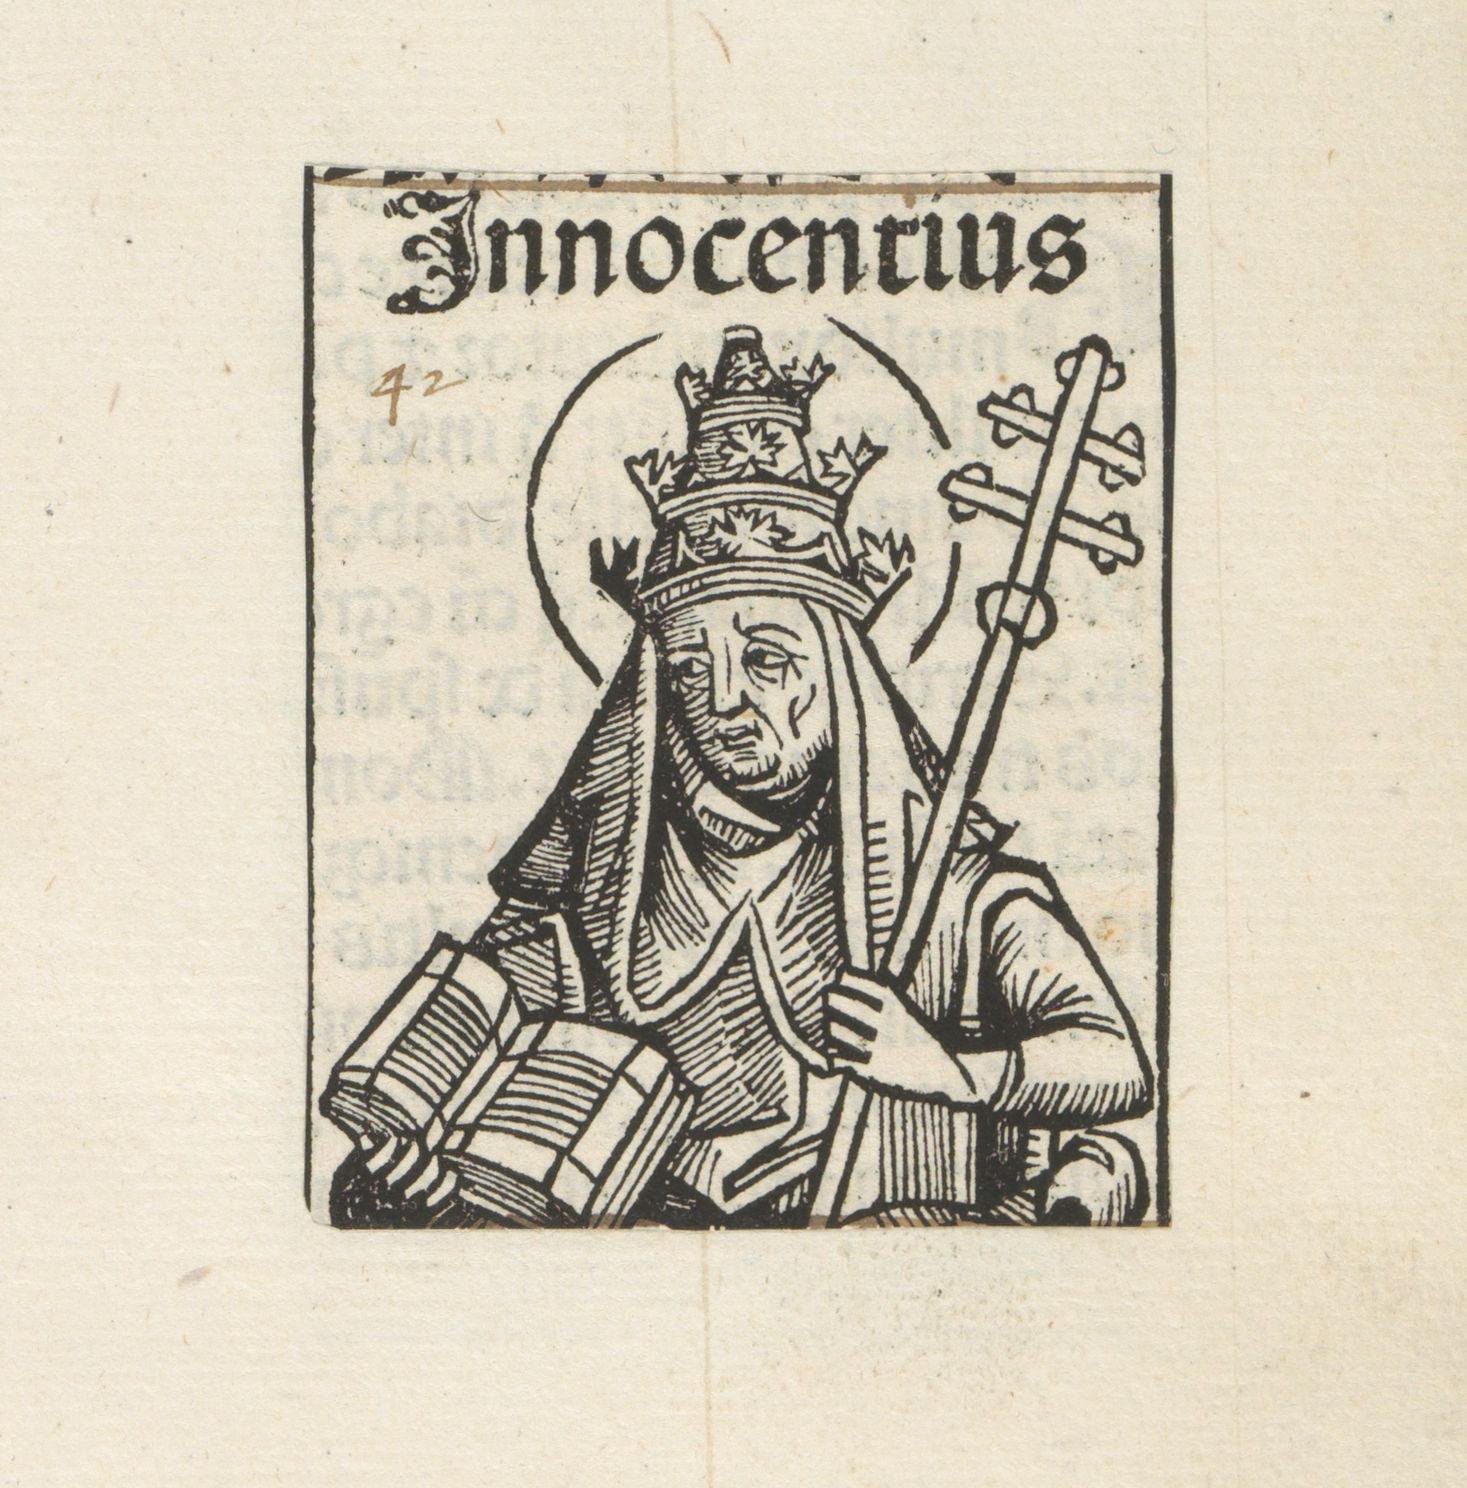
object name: album leaf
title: Paus Innocentius I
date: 1493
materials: paper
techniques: letterpress printing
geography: nuremberg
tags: pope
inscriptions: inscription: ‘42’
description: Een bloemkelk met een paus. Hij draagt een tiara en heeft een opengeslagen bijbel en een staf met dubbel kruis in zijn handen. De nimbus om zijn hoofd vertelt dat de paus heilig is verklaard. De voorstelling is onderdeel van de opeenvolging pausen in de Liber Chronicarum. De tekst identificeert de man als Innocentius I. De prent maakt deel uit van een album.